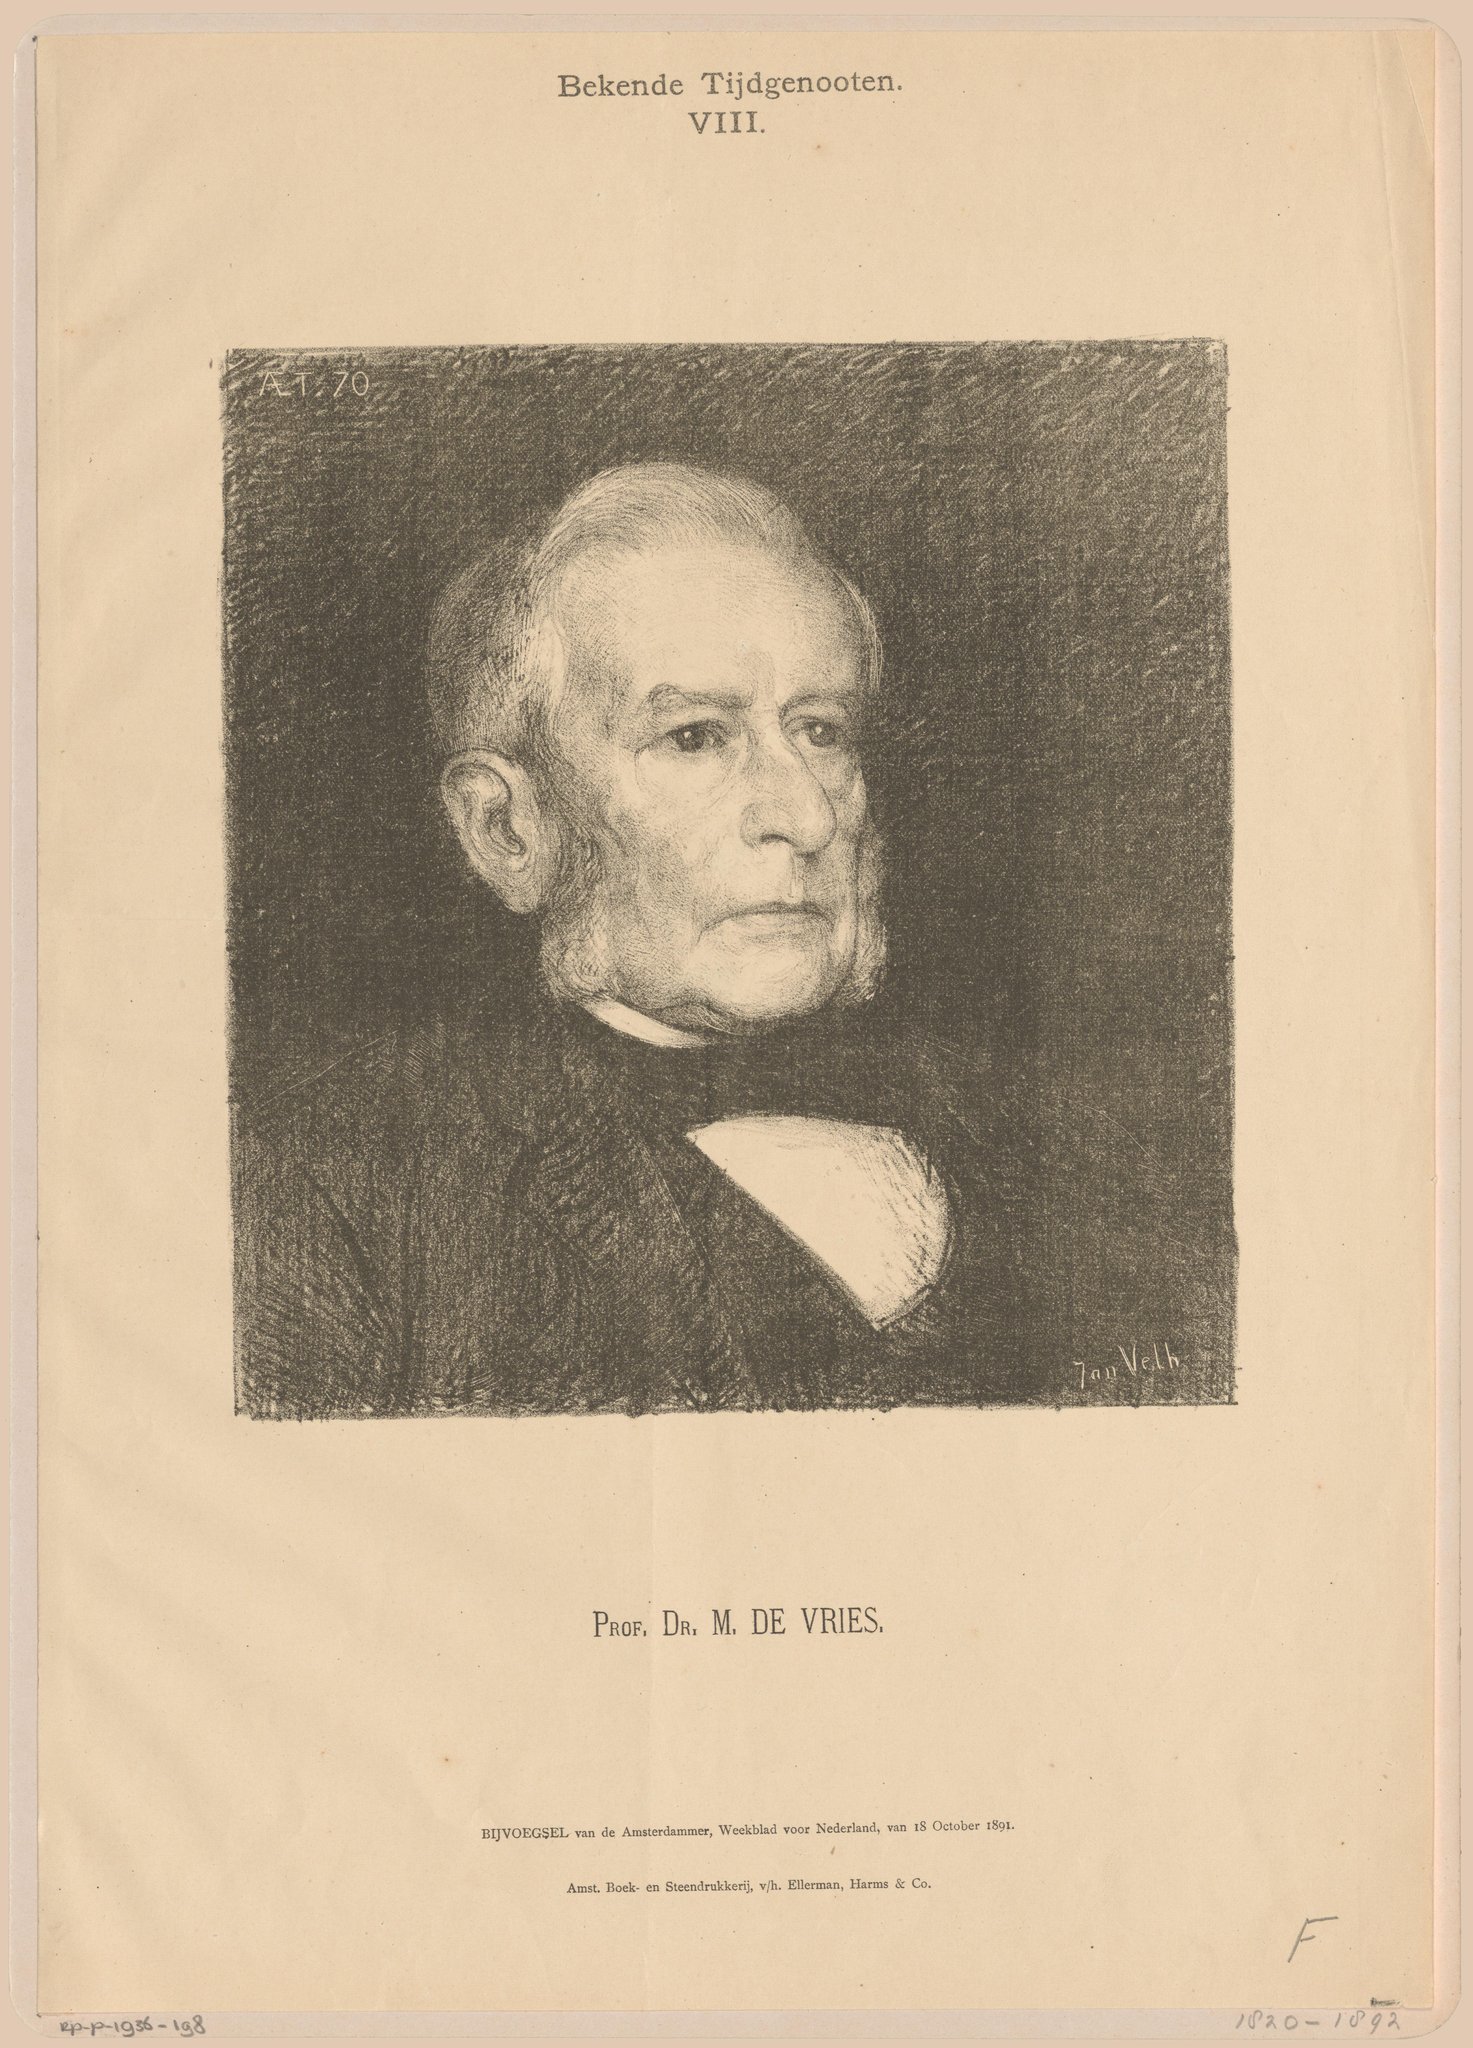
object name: print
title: Portret van Matthias de Vries op 70-jarige leeftijd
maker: jan veth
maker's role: designer, draughtsman, painter, print maker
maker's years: 1864-1925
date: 1891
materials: paper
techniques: lithograph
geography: amsterdam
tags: scholar, philosopher, historical persons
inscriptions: collector's mark: Lugt 2228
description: Deze prent werd uitgegeven als bijvoegsel van De Amsterdammer op 18 oktober 1891.